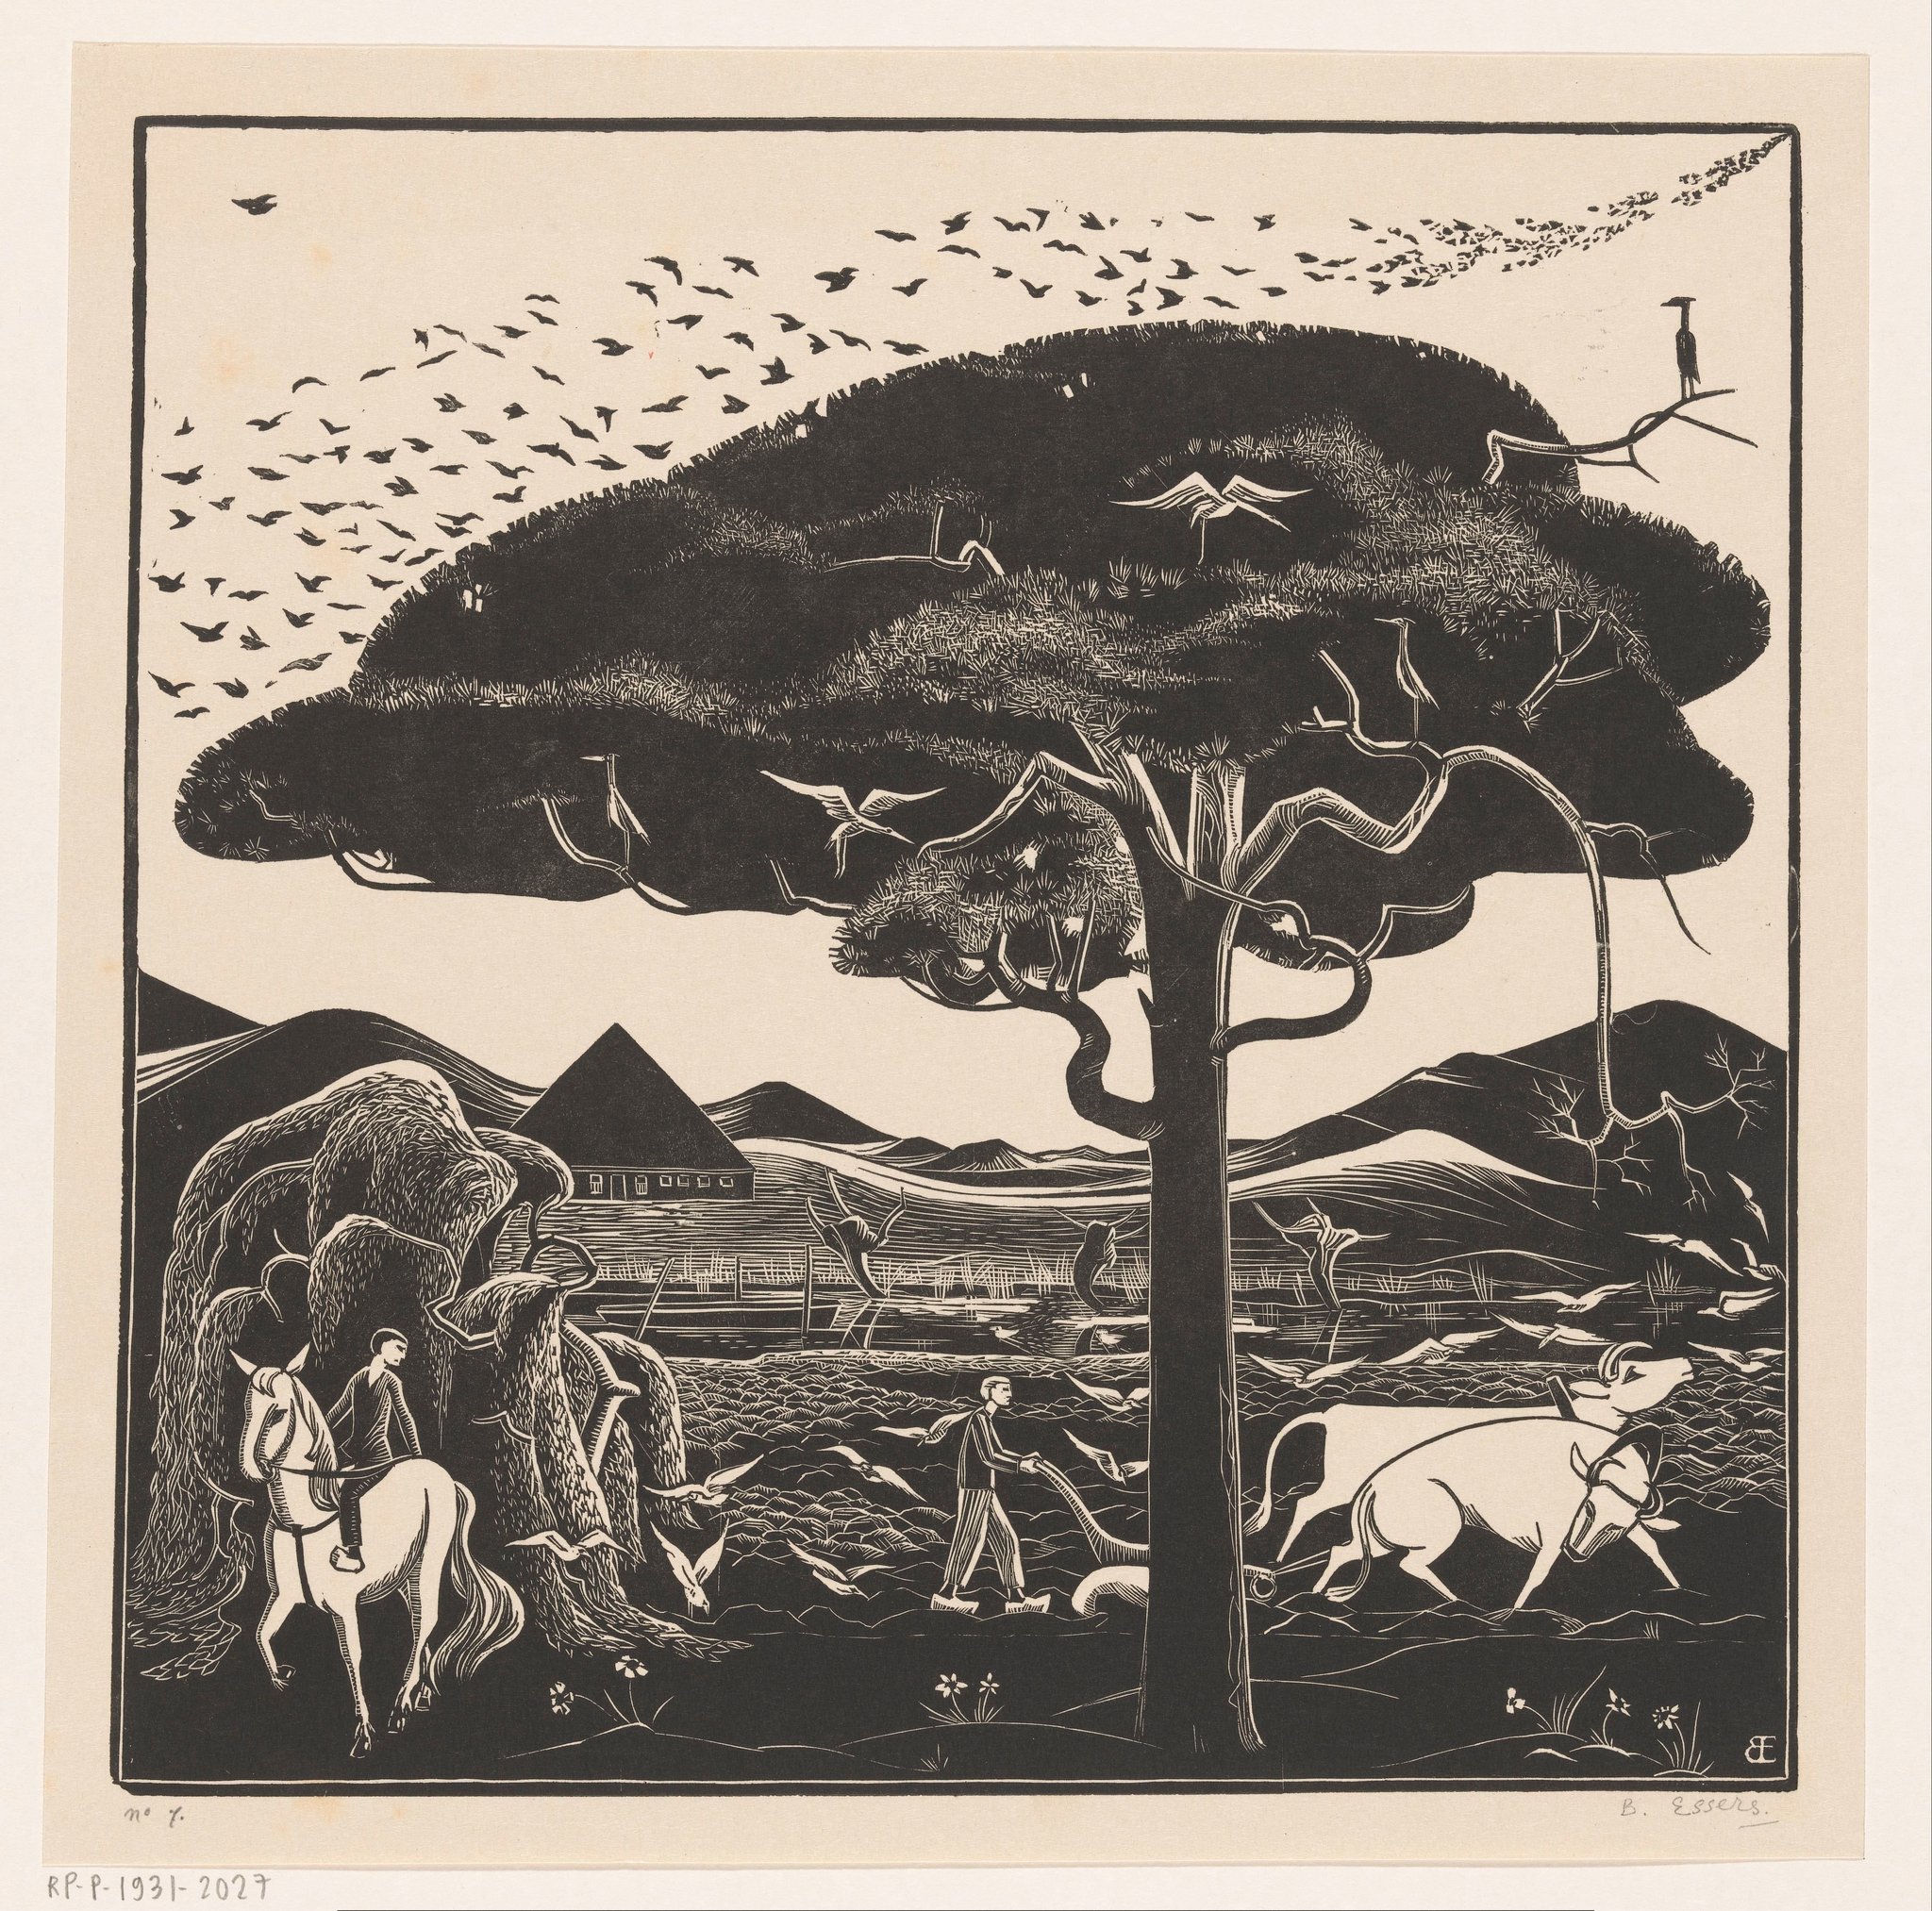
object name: print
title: Ploegende ossen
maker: bernard essers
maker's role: print maker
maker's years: 1893-1945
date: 1927-1928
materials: paper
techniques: engraving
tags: trees, ox, farm or solitary house in landscape, ploughing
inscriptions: collector's mark: Lugt 2228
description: Twee ossen trekken een ploeg door een akker. Een man op klompen loopt achter hen. Links op de voorgrond een man op klompen gezeten op een paard. Rechts een boom met vogels, mogelijk reigers. In de lucht een zwerm vogels. Op de achtergrond een boerderij in een heuvellandschap.